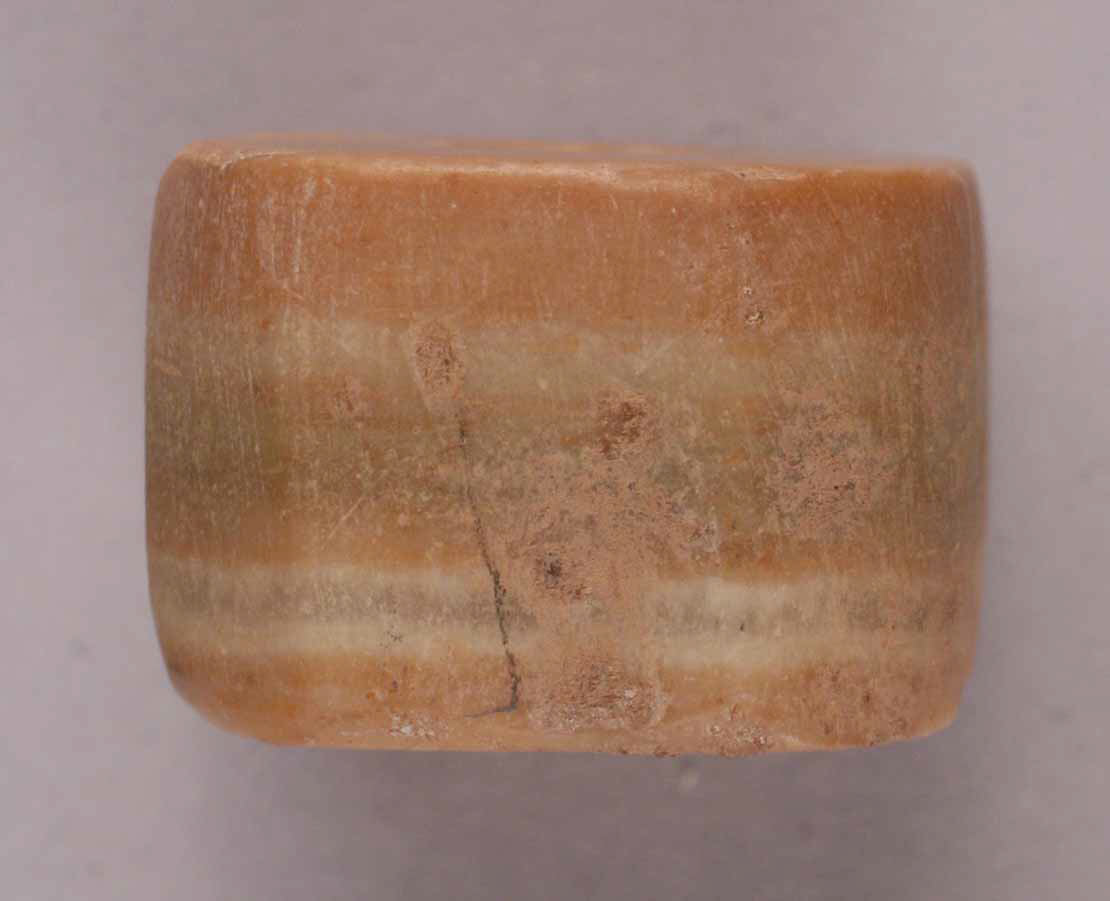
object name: bead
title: Beads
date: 701-1300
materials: stone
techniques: cutting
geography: iran